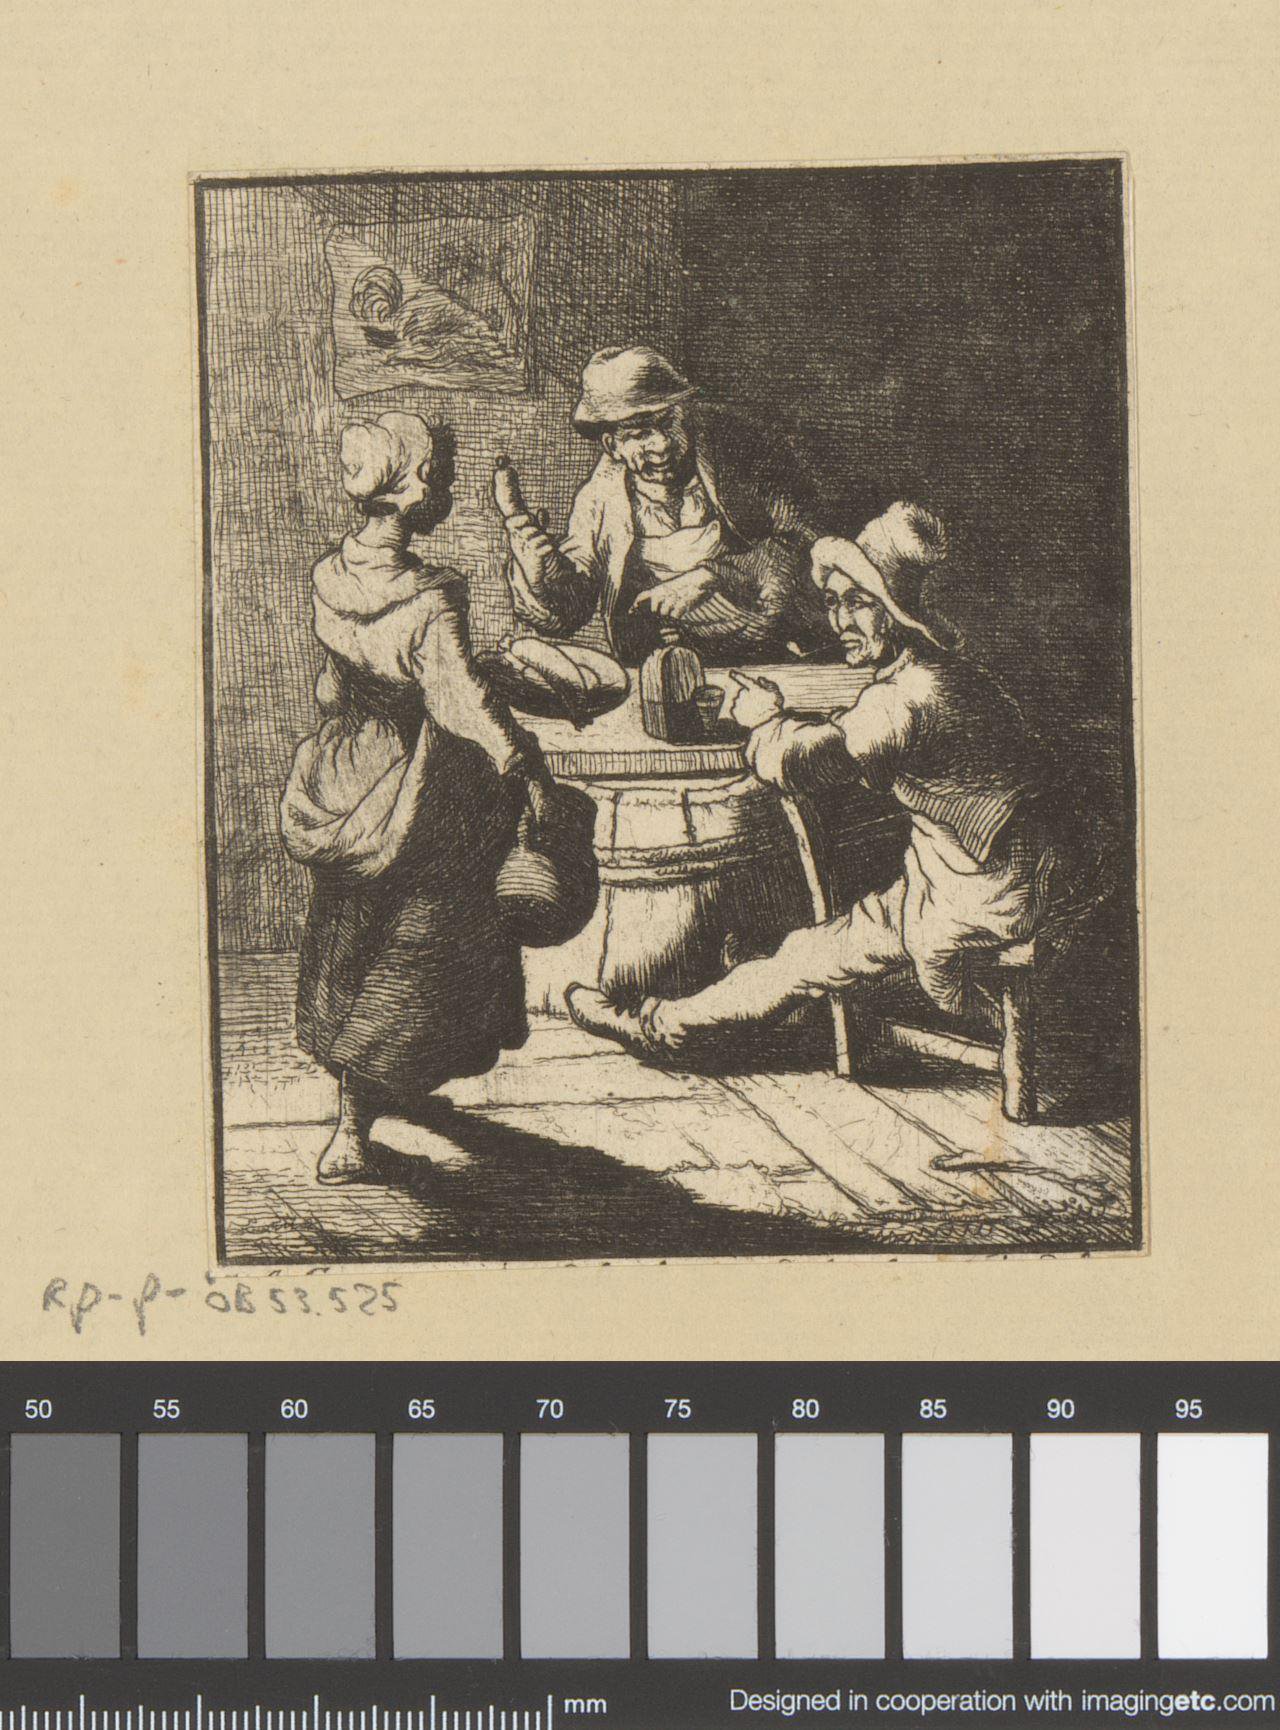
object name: print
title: Twee mannen aan tafel, een vrouw draagt worst en drank aan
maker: carl august grossmann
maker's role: print maker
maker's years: 1741-1798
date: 1760-1798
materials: paper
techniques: etching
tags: giving food, inn, coffee-house, public house, etc., drinking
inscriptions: collector's mark: Lugt 240